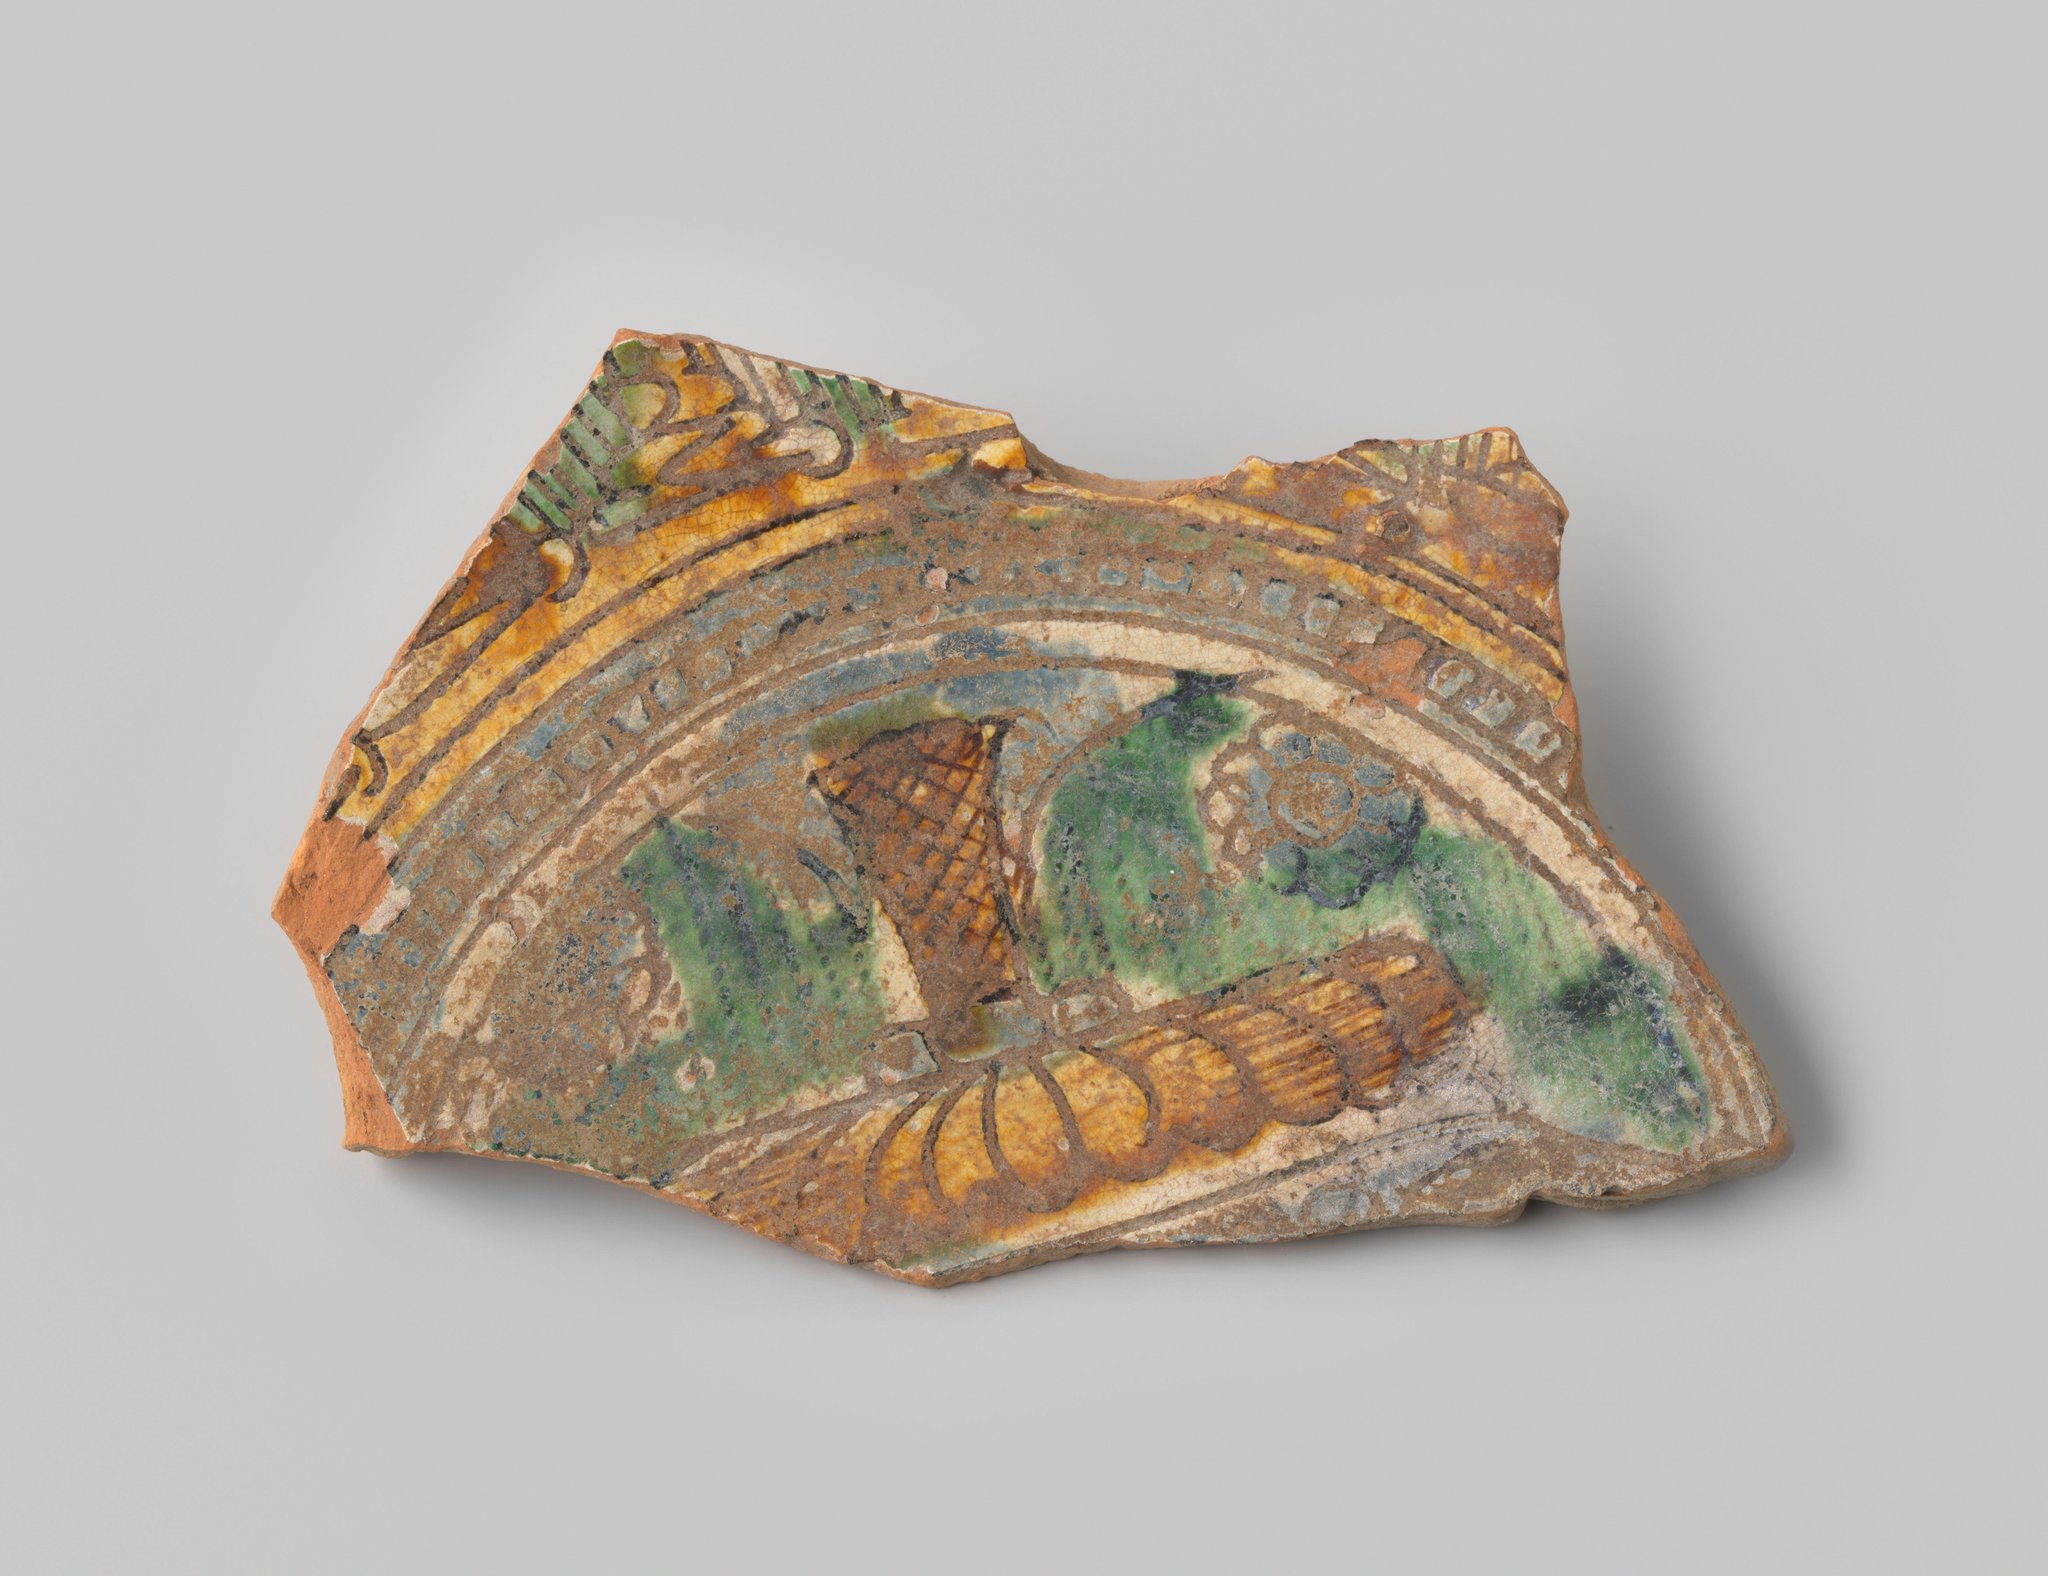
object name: sherd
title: Schotelscherf van roodbakkend aardewerk, aan de voorzijde voorzien van een vaas op voet in een cirkel, in sgrafitto-techniek met wit, geel, groen en blauw glazuur, aan de achterzijde ongeglazuurd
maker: Anonymous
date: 1200-1899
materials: earthenware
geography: italy